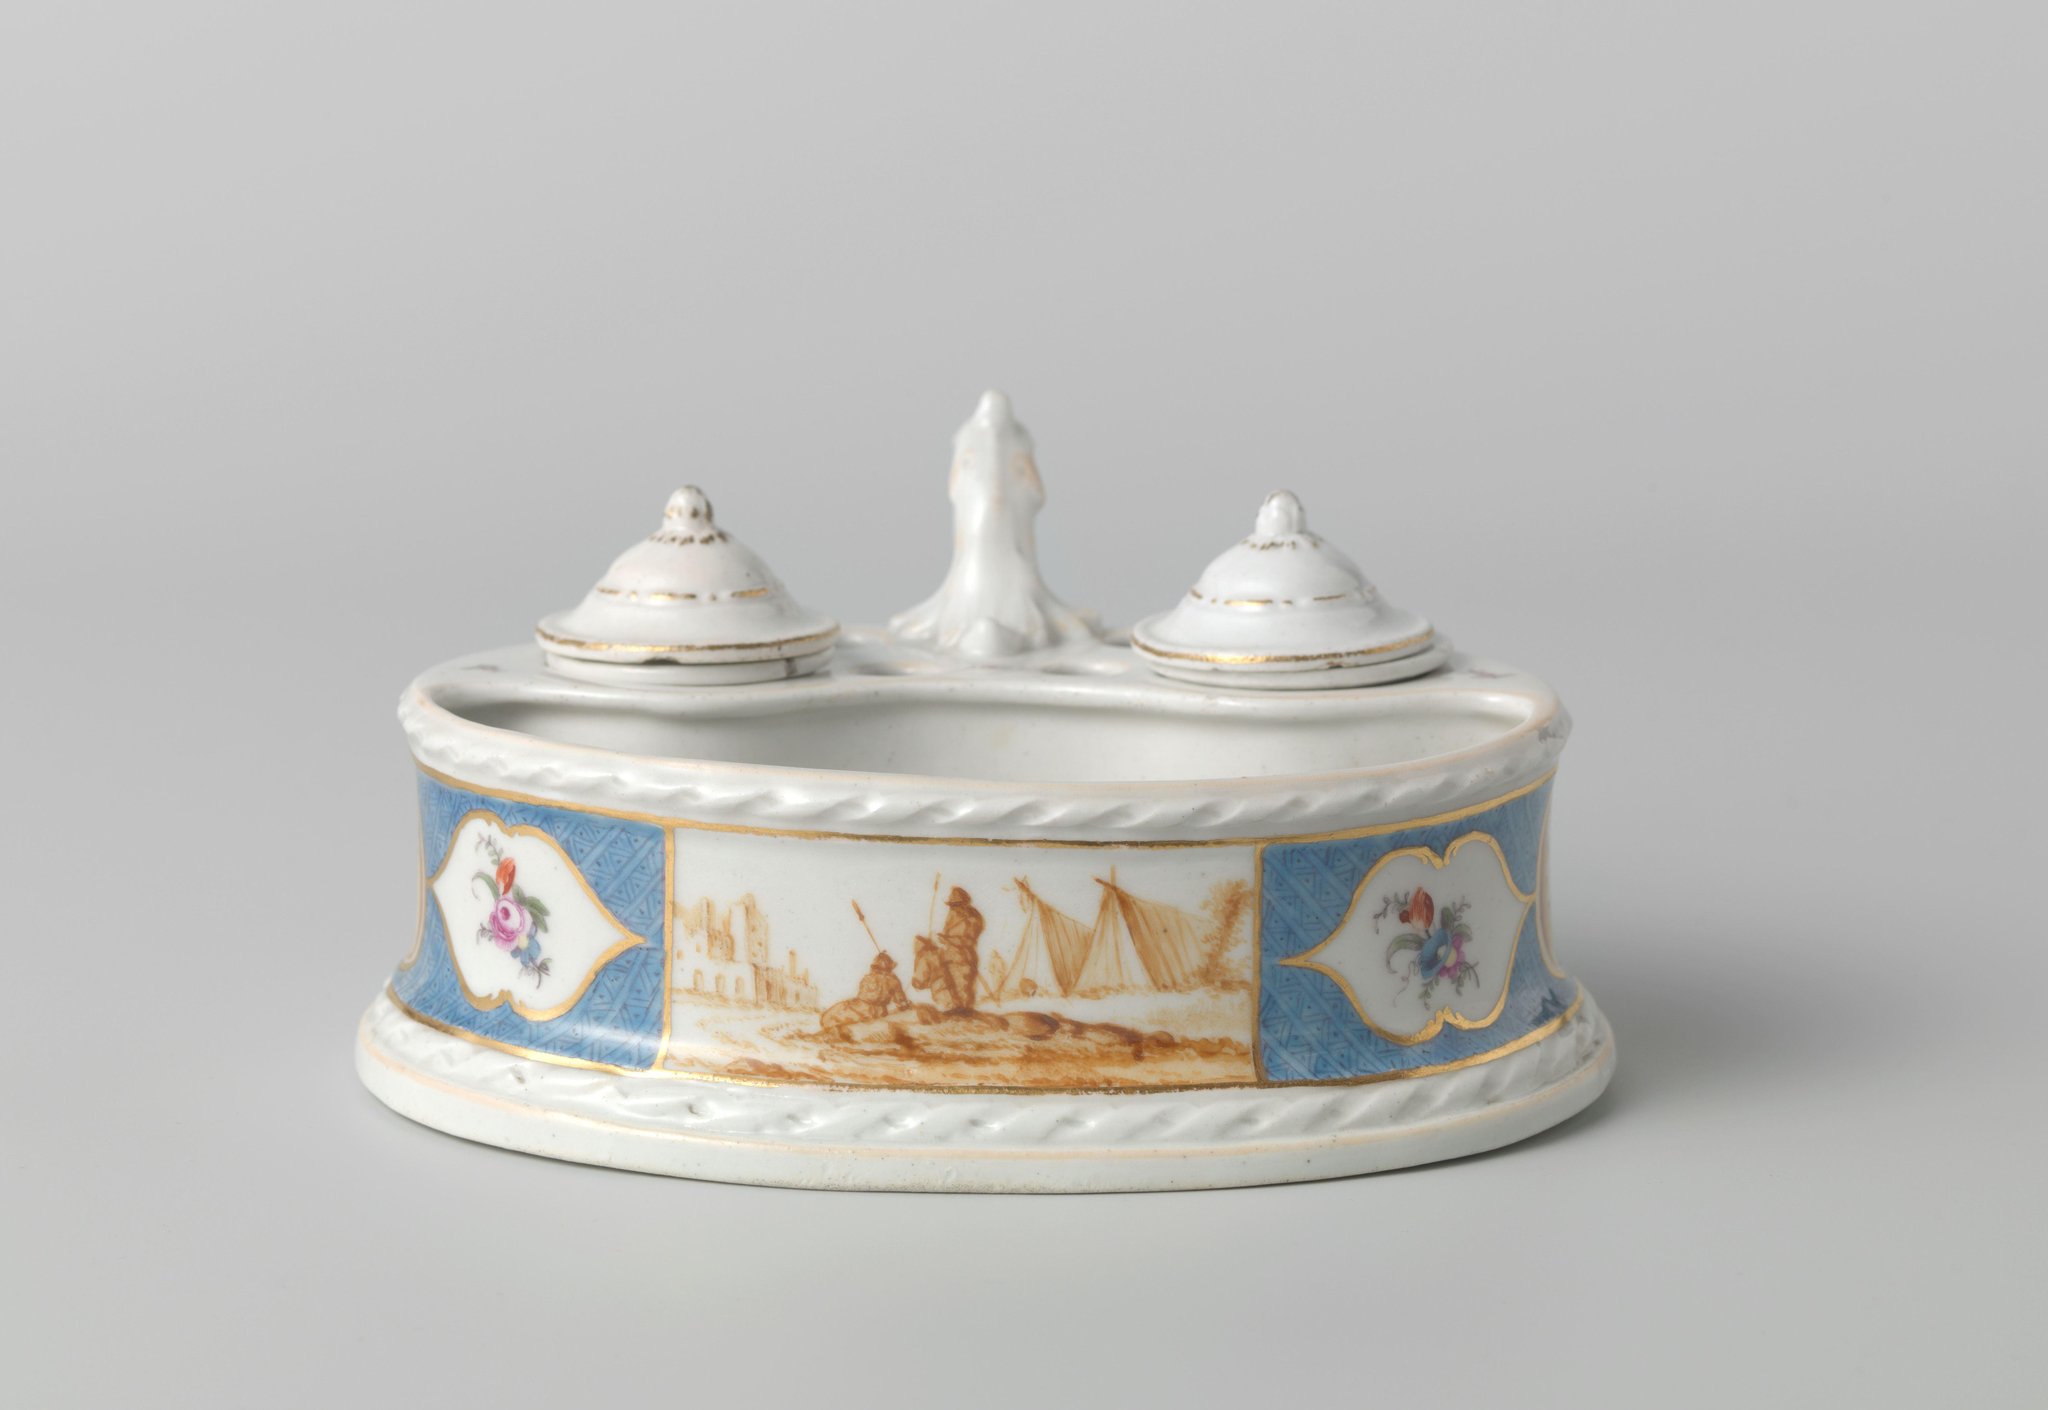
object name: inkstand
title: Inktstel, beschilderd met een landschap met figuren bij tenten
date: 1778-1782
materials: porcelain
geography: loosdrecht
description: Inktstel van porselein. Ovaal met oor aan één zijde. In het aan de bovenzijde afgesloten gedeelte twee grote ronde openingen voor een inktpotje en een zandstrooier en vier gaten voor pennen. Langs boven- en onderrand een gevlochten lintmotief in reliëf. Beschilderd aan de voorkant met een landschap met figuren bij tenten in sepia in een rechthoekig veld, dat een fries van lichtblauw traliewerk onderbreekt. In dit traliewerk zijn aan de zijkanten drie cartouches uitgespaard, waarvan de middelste een medaillon met bekranste mannenkop in sepia is, de andere twee spits toelopen en een veelkleurige bloemtak bevatten. Aan de achterzijde is een ovaal met strooibloempjes uitgespaard, in het midden waarvan de aanzet van het oor zich bevindt. Op wand gouden biezen.